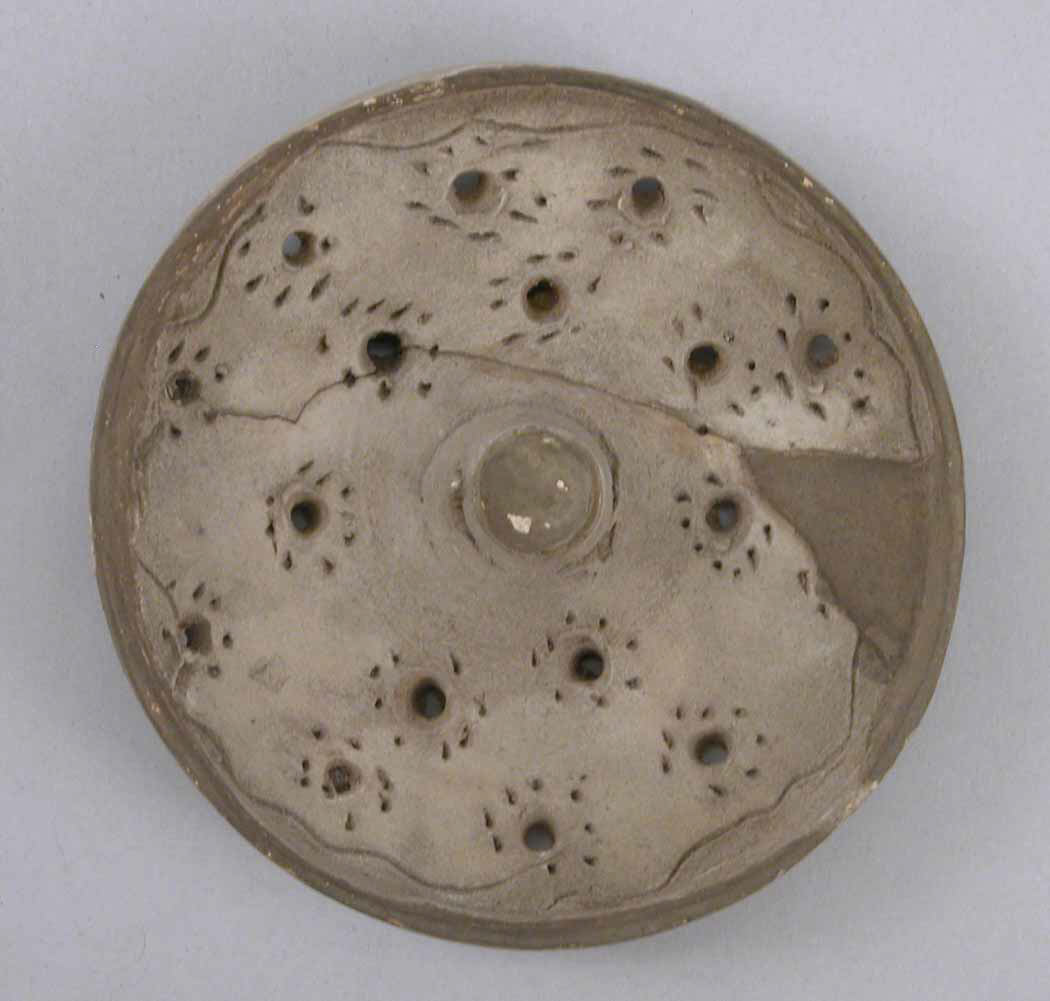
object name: lid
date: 801-900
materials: earthenware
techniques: incising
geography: iran